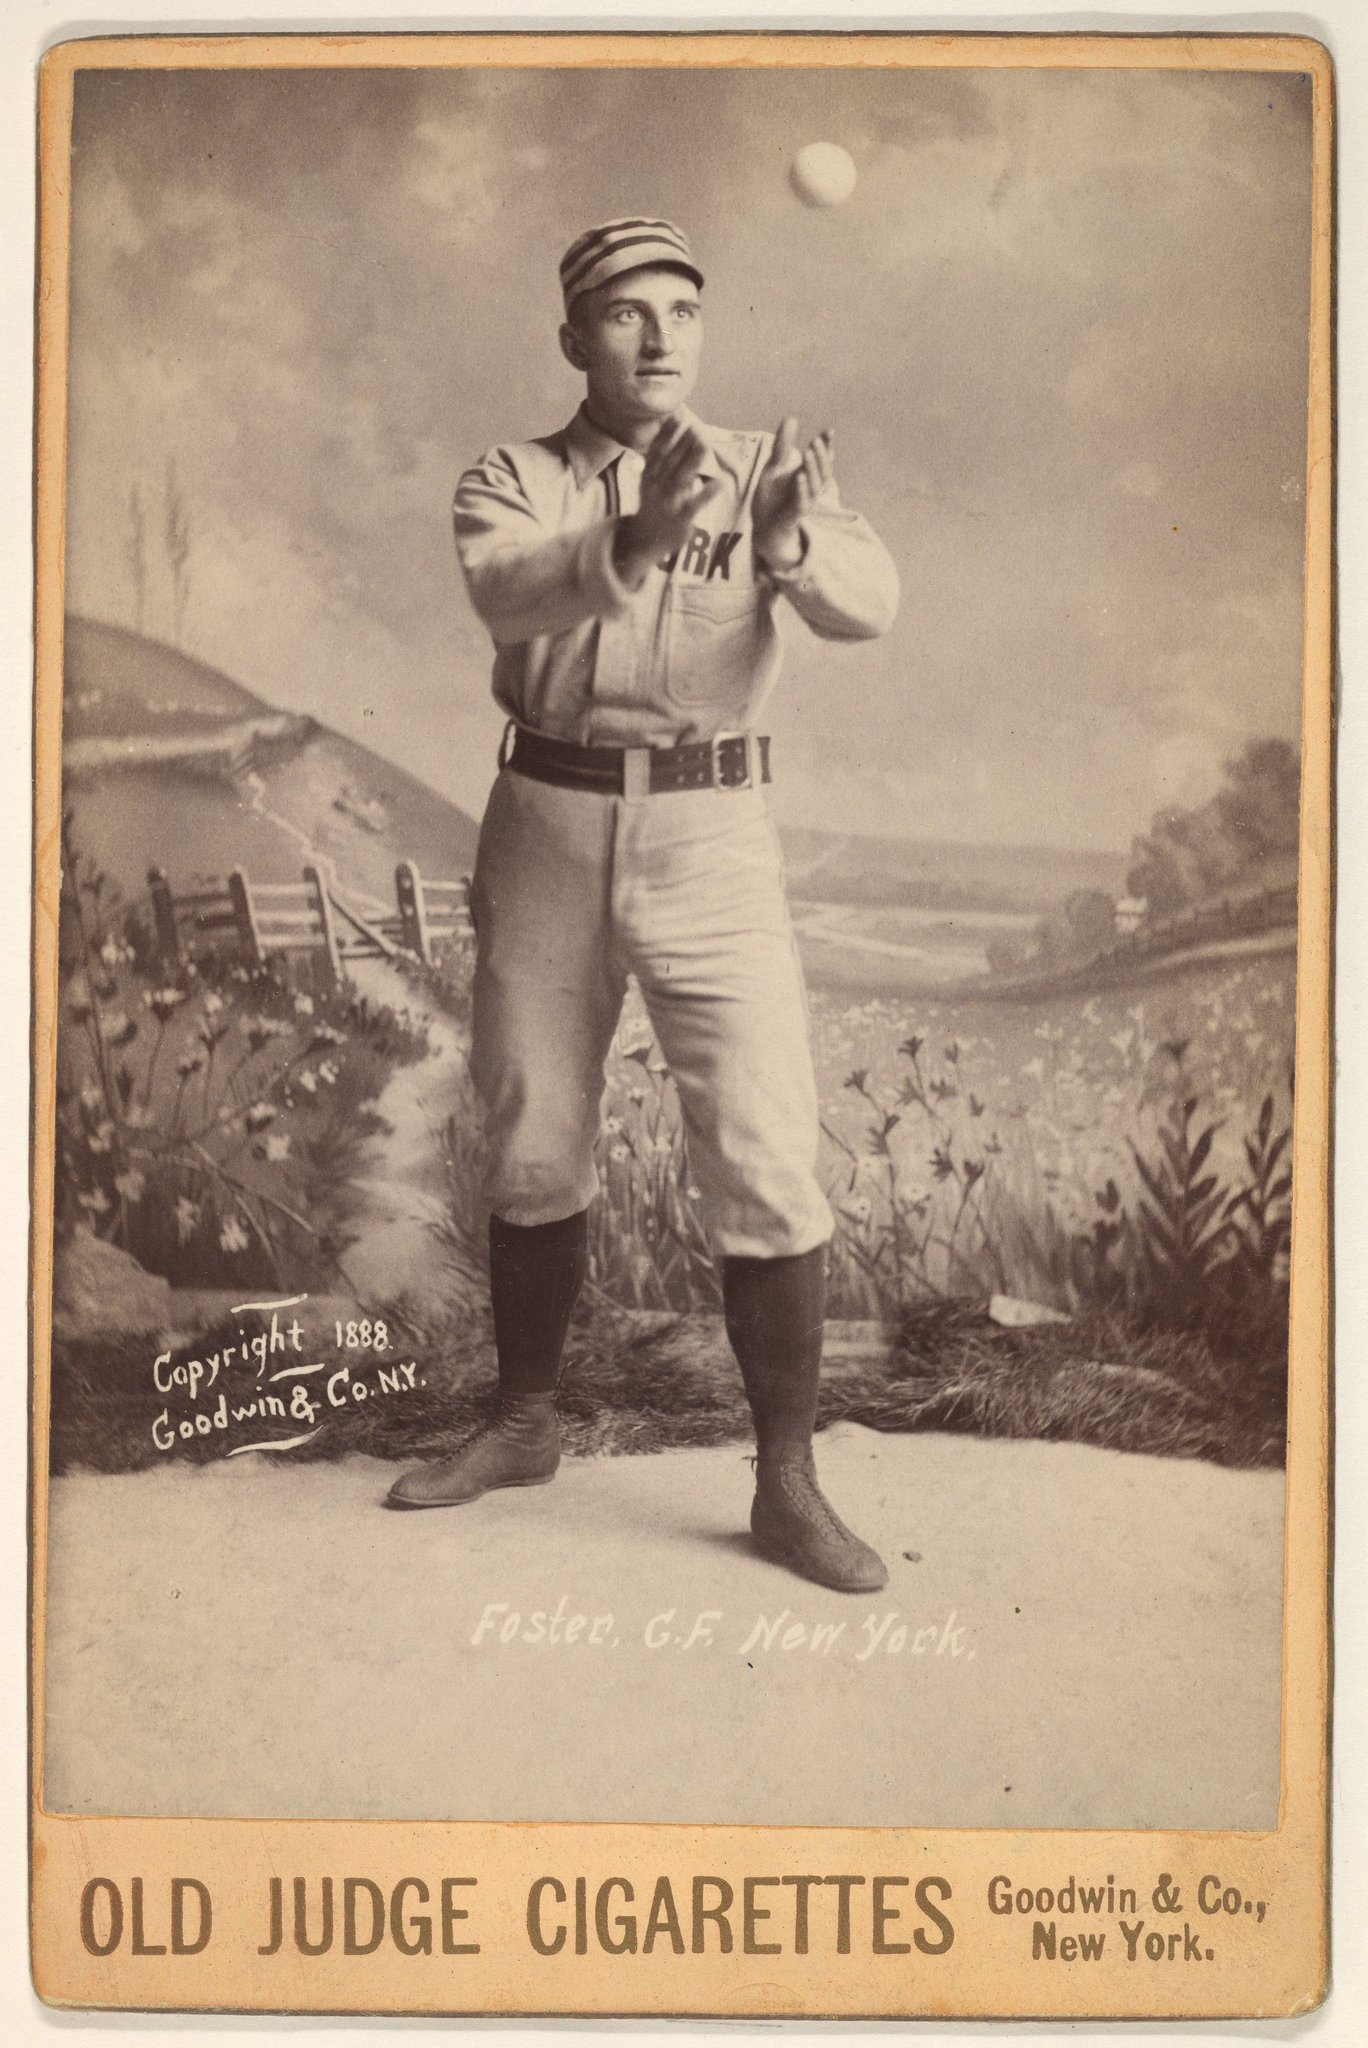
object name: baseball card, photograph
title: Foster, Center Field, New York, from the series Old Judge Cigarettes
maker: goodwin & company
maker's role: publisher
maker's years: 1850-1950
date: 1888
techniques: albumen silver print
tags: men,portraits,baseball,athletes